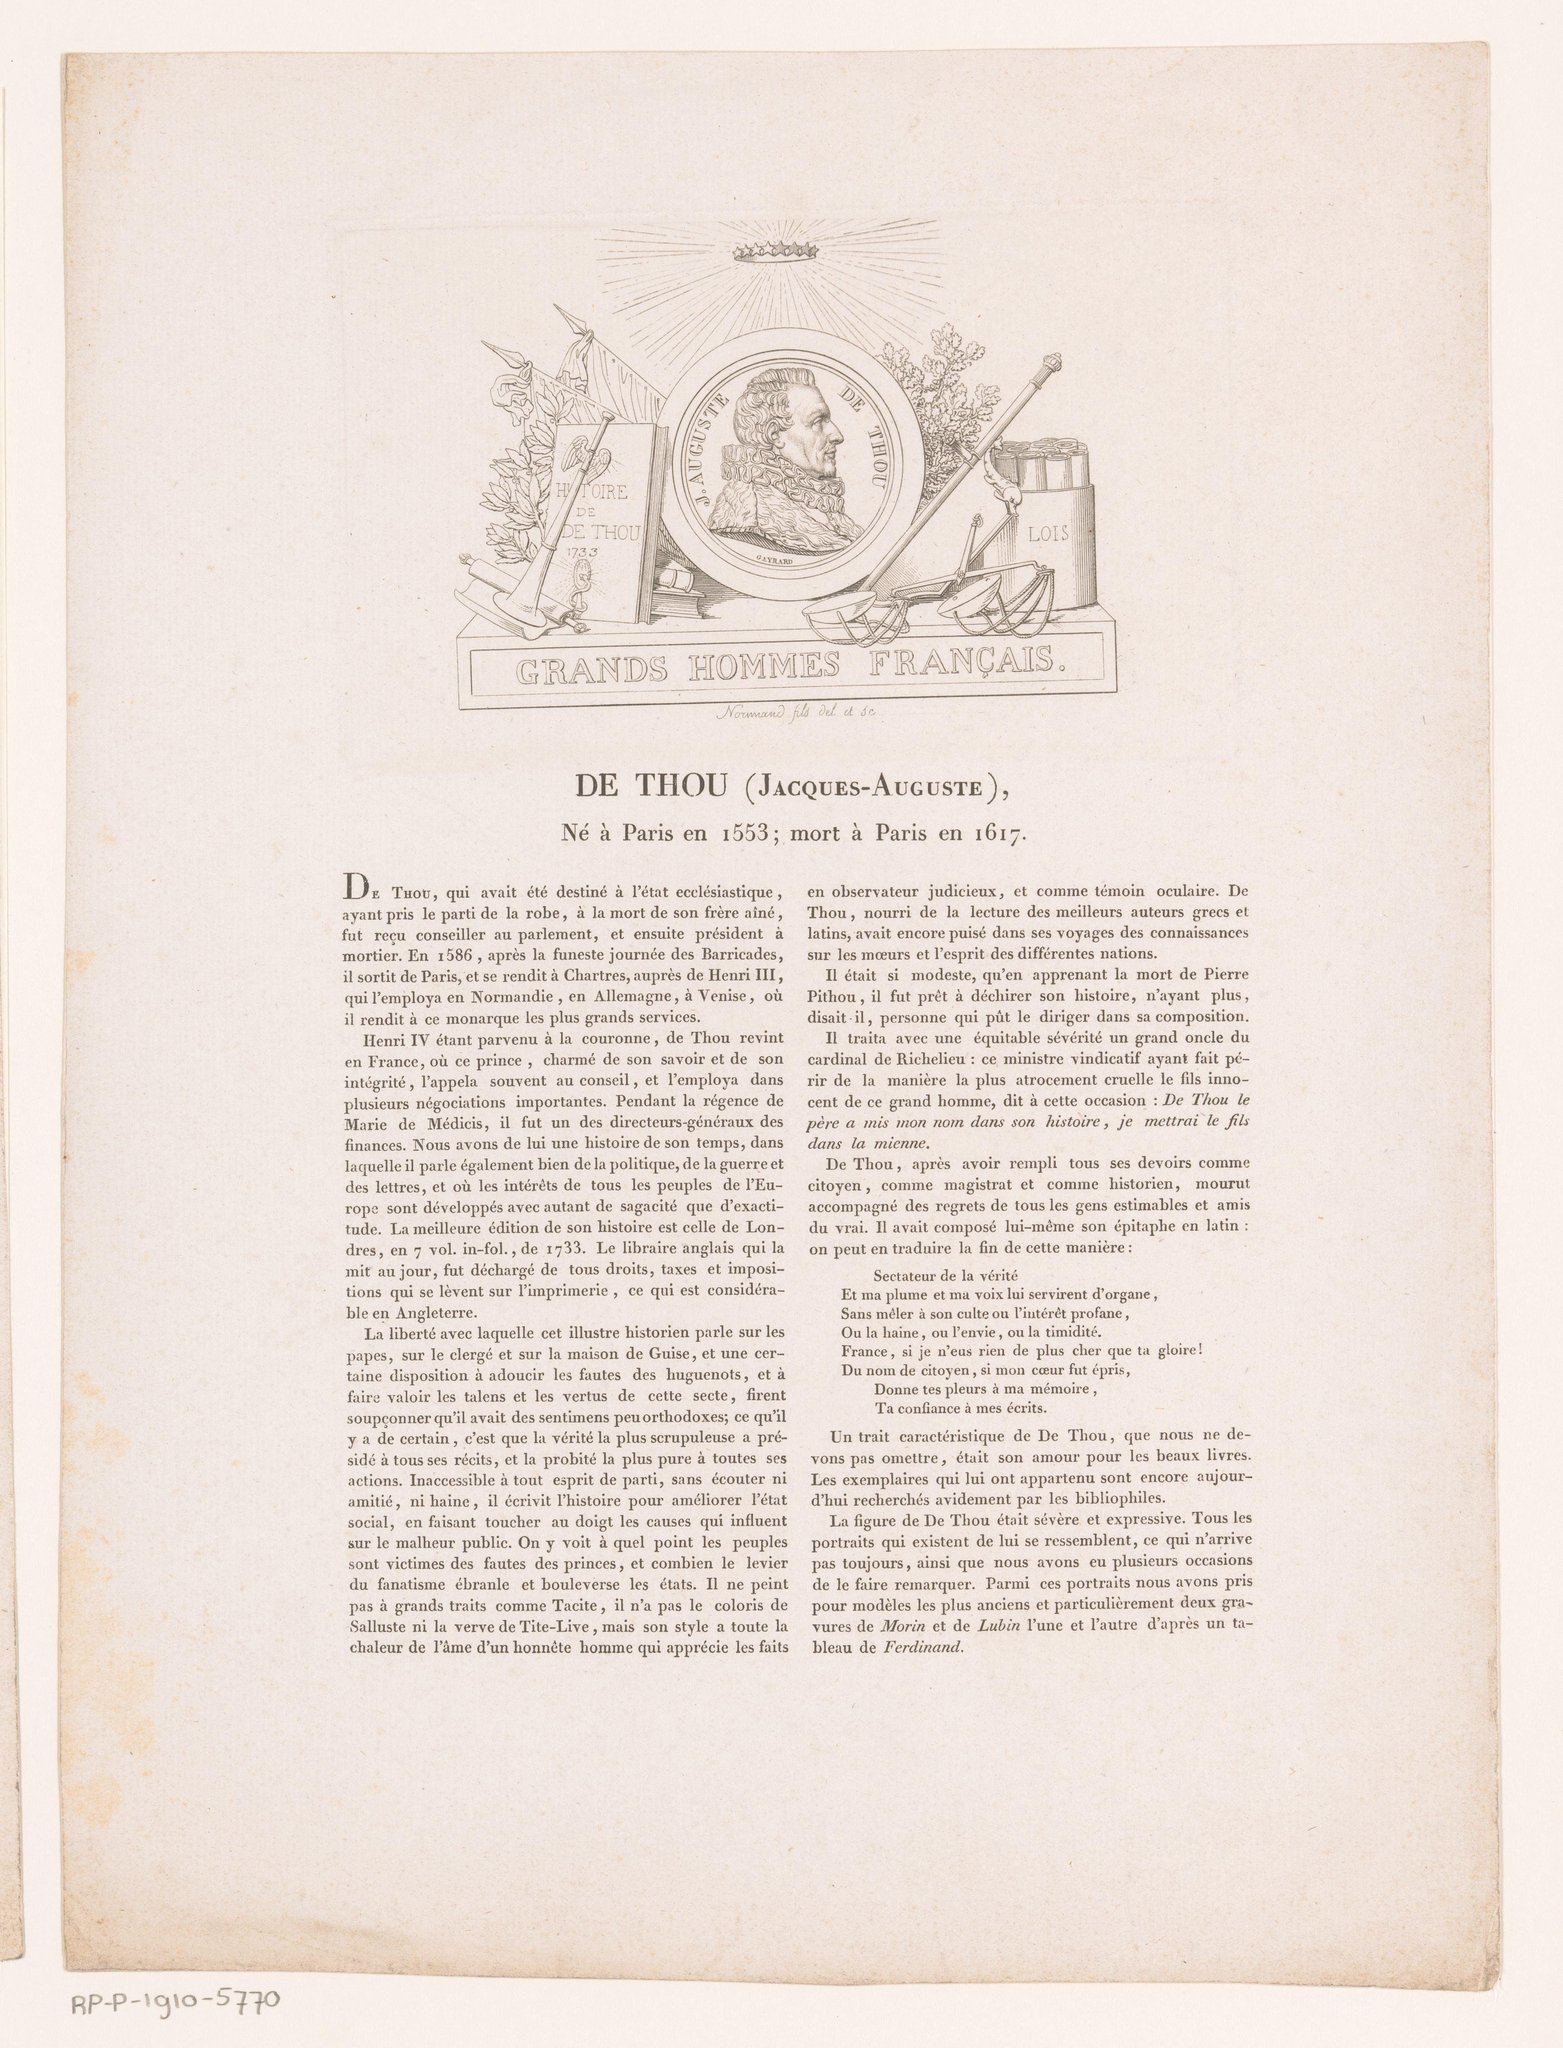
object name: print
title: Galerij van penningen met Franse grootheden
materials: paper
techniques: etching, letterpress printing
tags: paris, politician, historical persons, portrait of a writer, politician, e.g. party leader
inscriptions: collector's mark: Lugt 2228